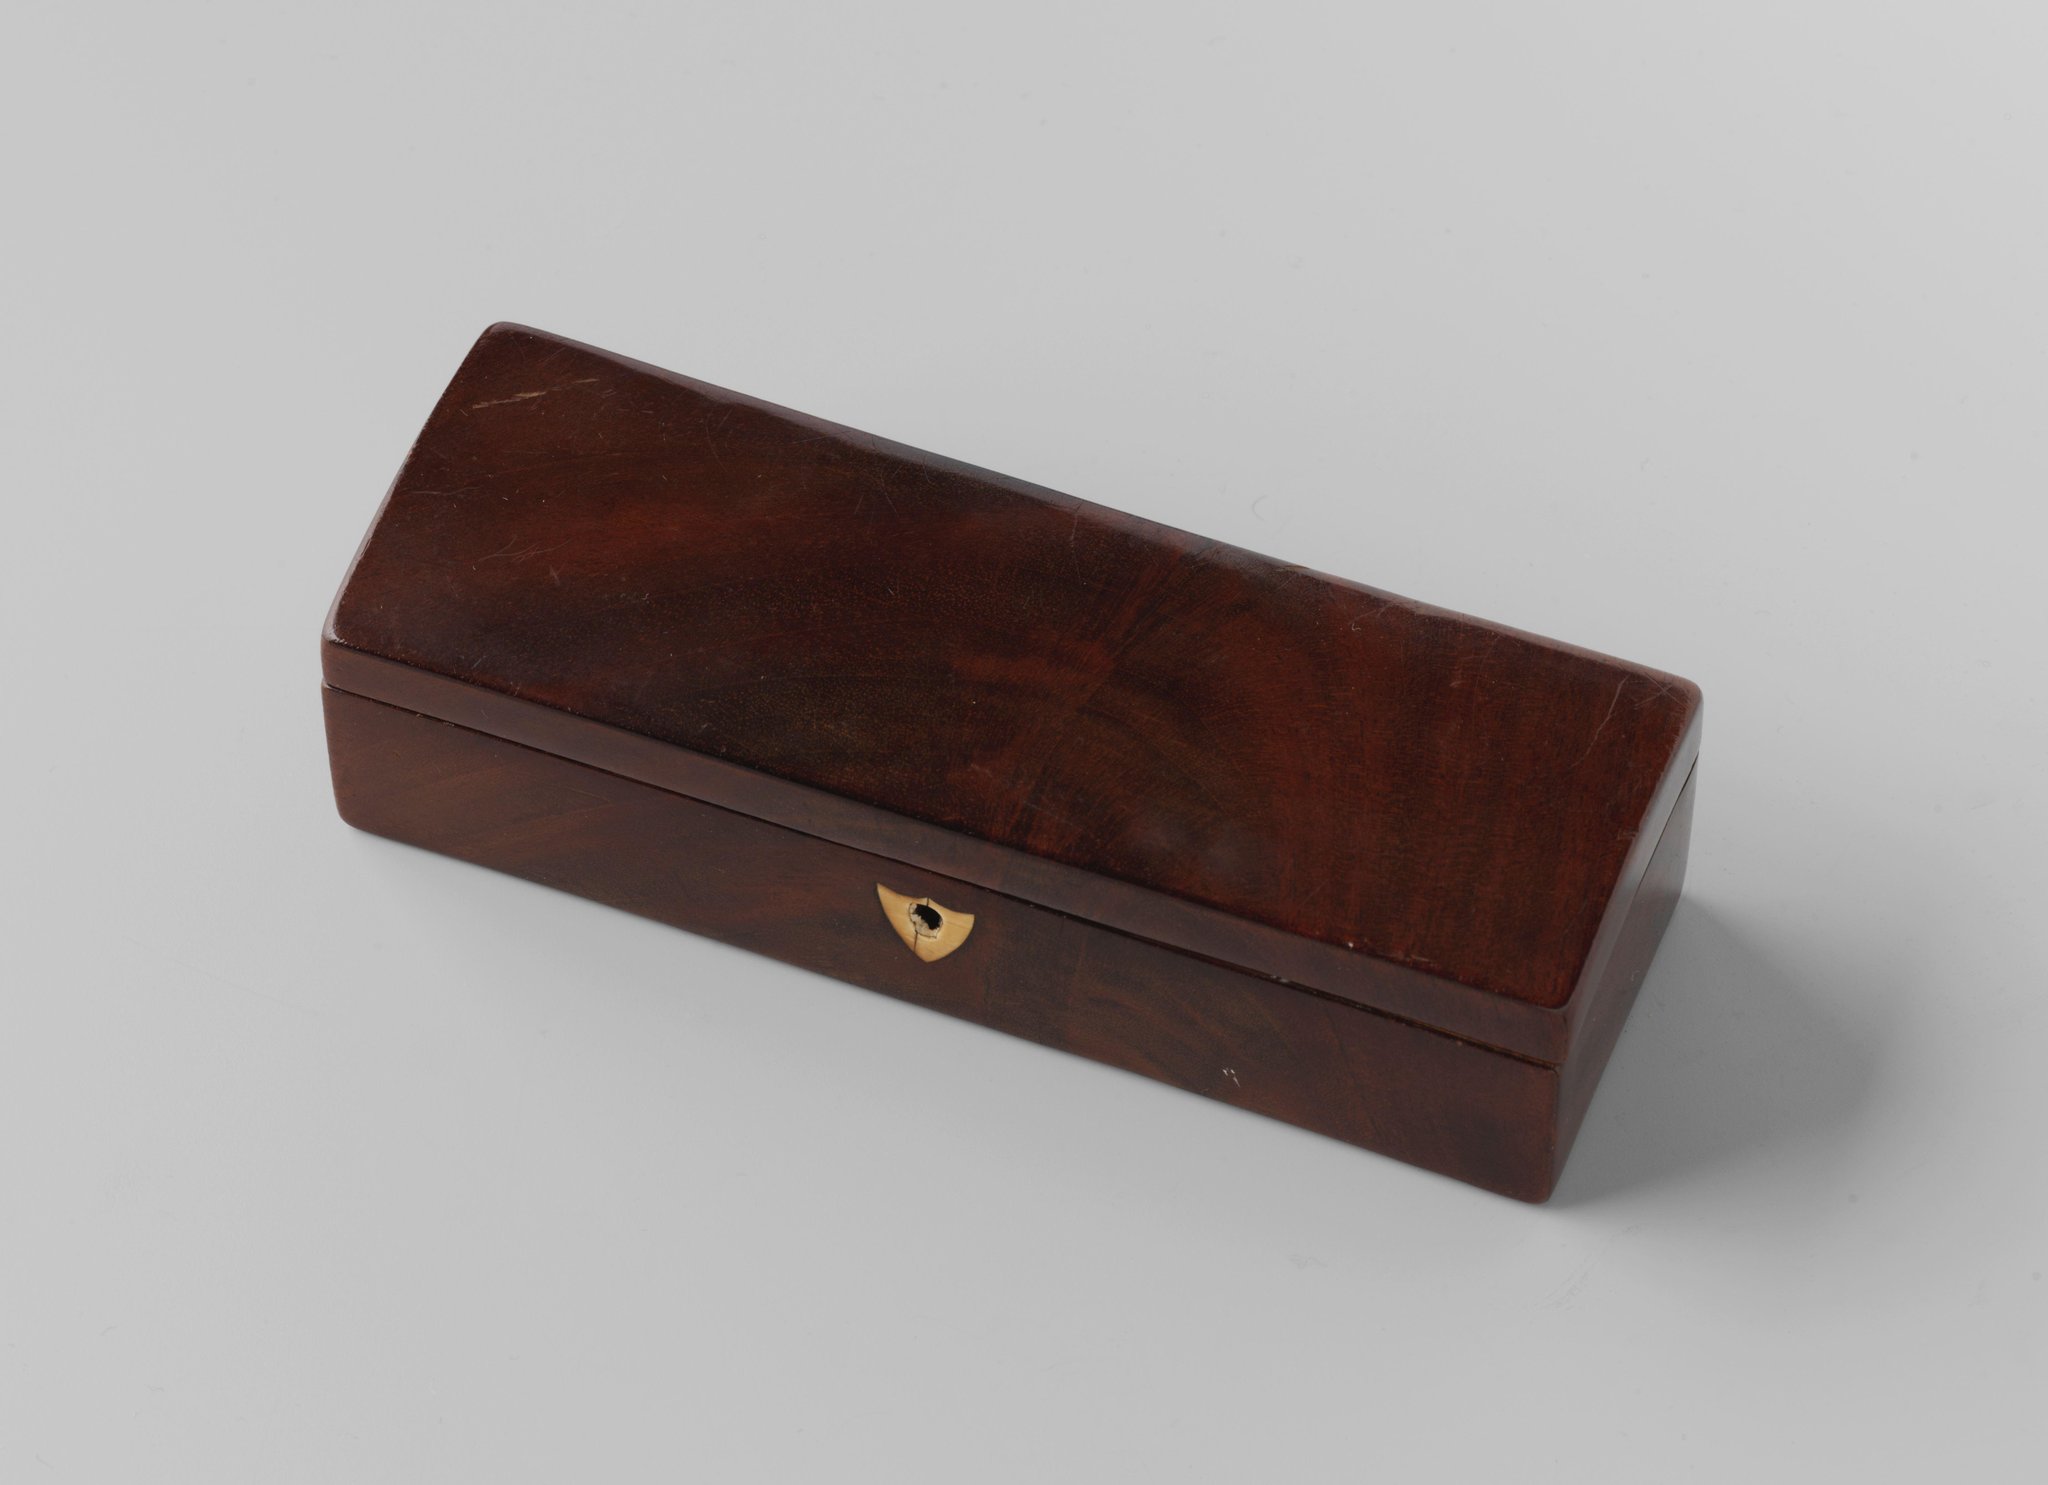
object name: box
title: Lepeldoos van mahoniehout, rood gevoerd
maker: Anonymous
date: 1868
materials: wood, silver, velvet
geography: netherlands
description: Lepeldoos van mahoniehout, rood gevoerd. Inhoud 6 theelepels (slechts 3 aangetroffen) afgezet met een fijn geribde kabel.